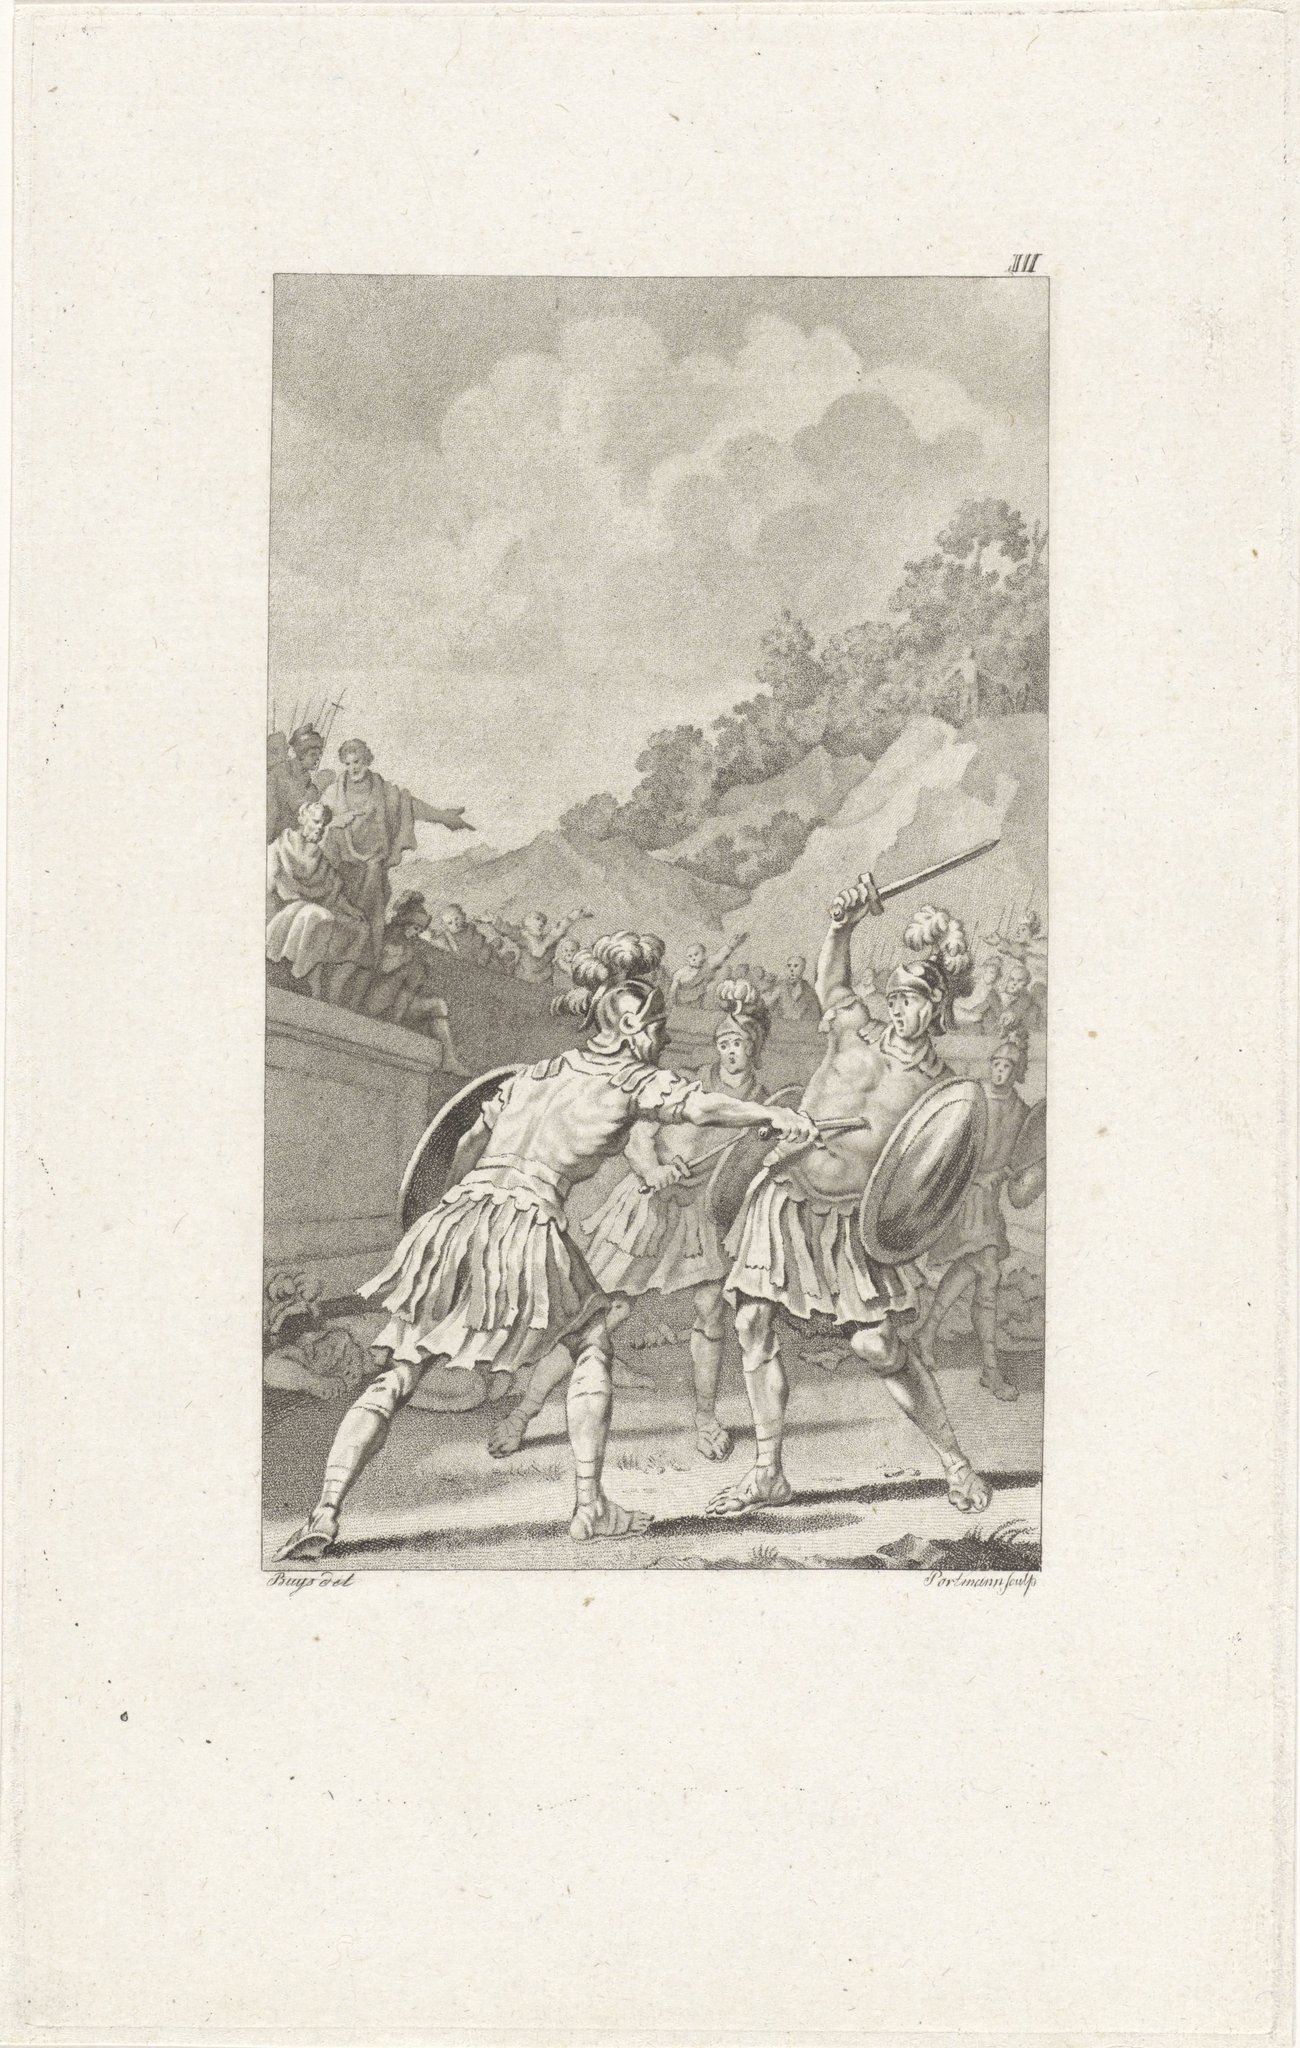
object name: book illustration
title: Duel tussen de Horatii en Curiatii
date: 1793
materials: paper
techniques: stippled etching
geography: utrecht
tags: two horatii being killed, the surviving brother defeats the three curiatii one by one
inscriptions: collector's mark: Lugt 2228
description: Duel tussen de Horatii en Curiatii, twee drielingen van respectievelijk Romeinse en Albaanse komaf, waarbij de oorlog wordt beslist. Hier doodt Publius Horatius de gewonde Curiatii een voor een. Romeinen moedigen hem aan.